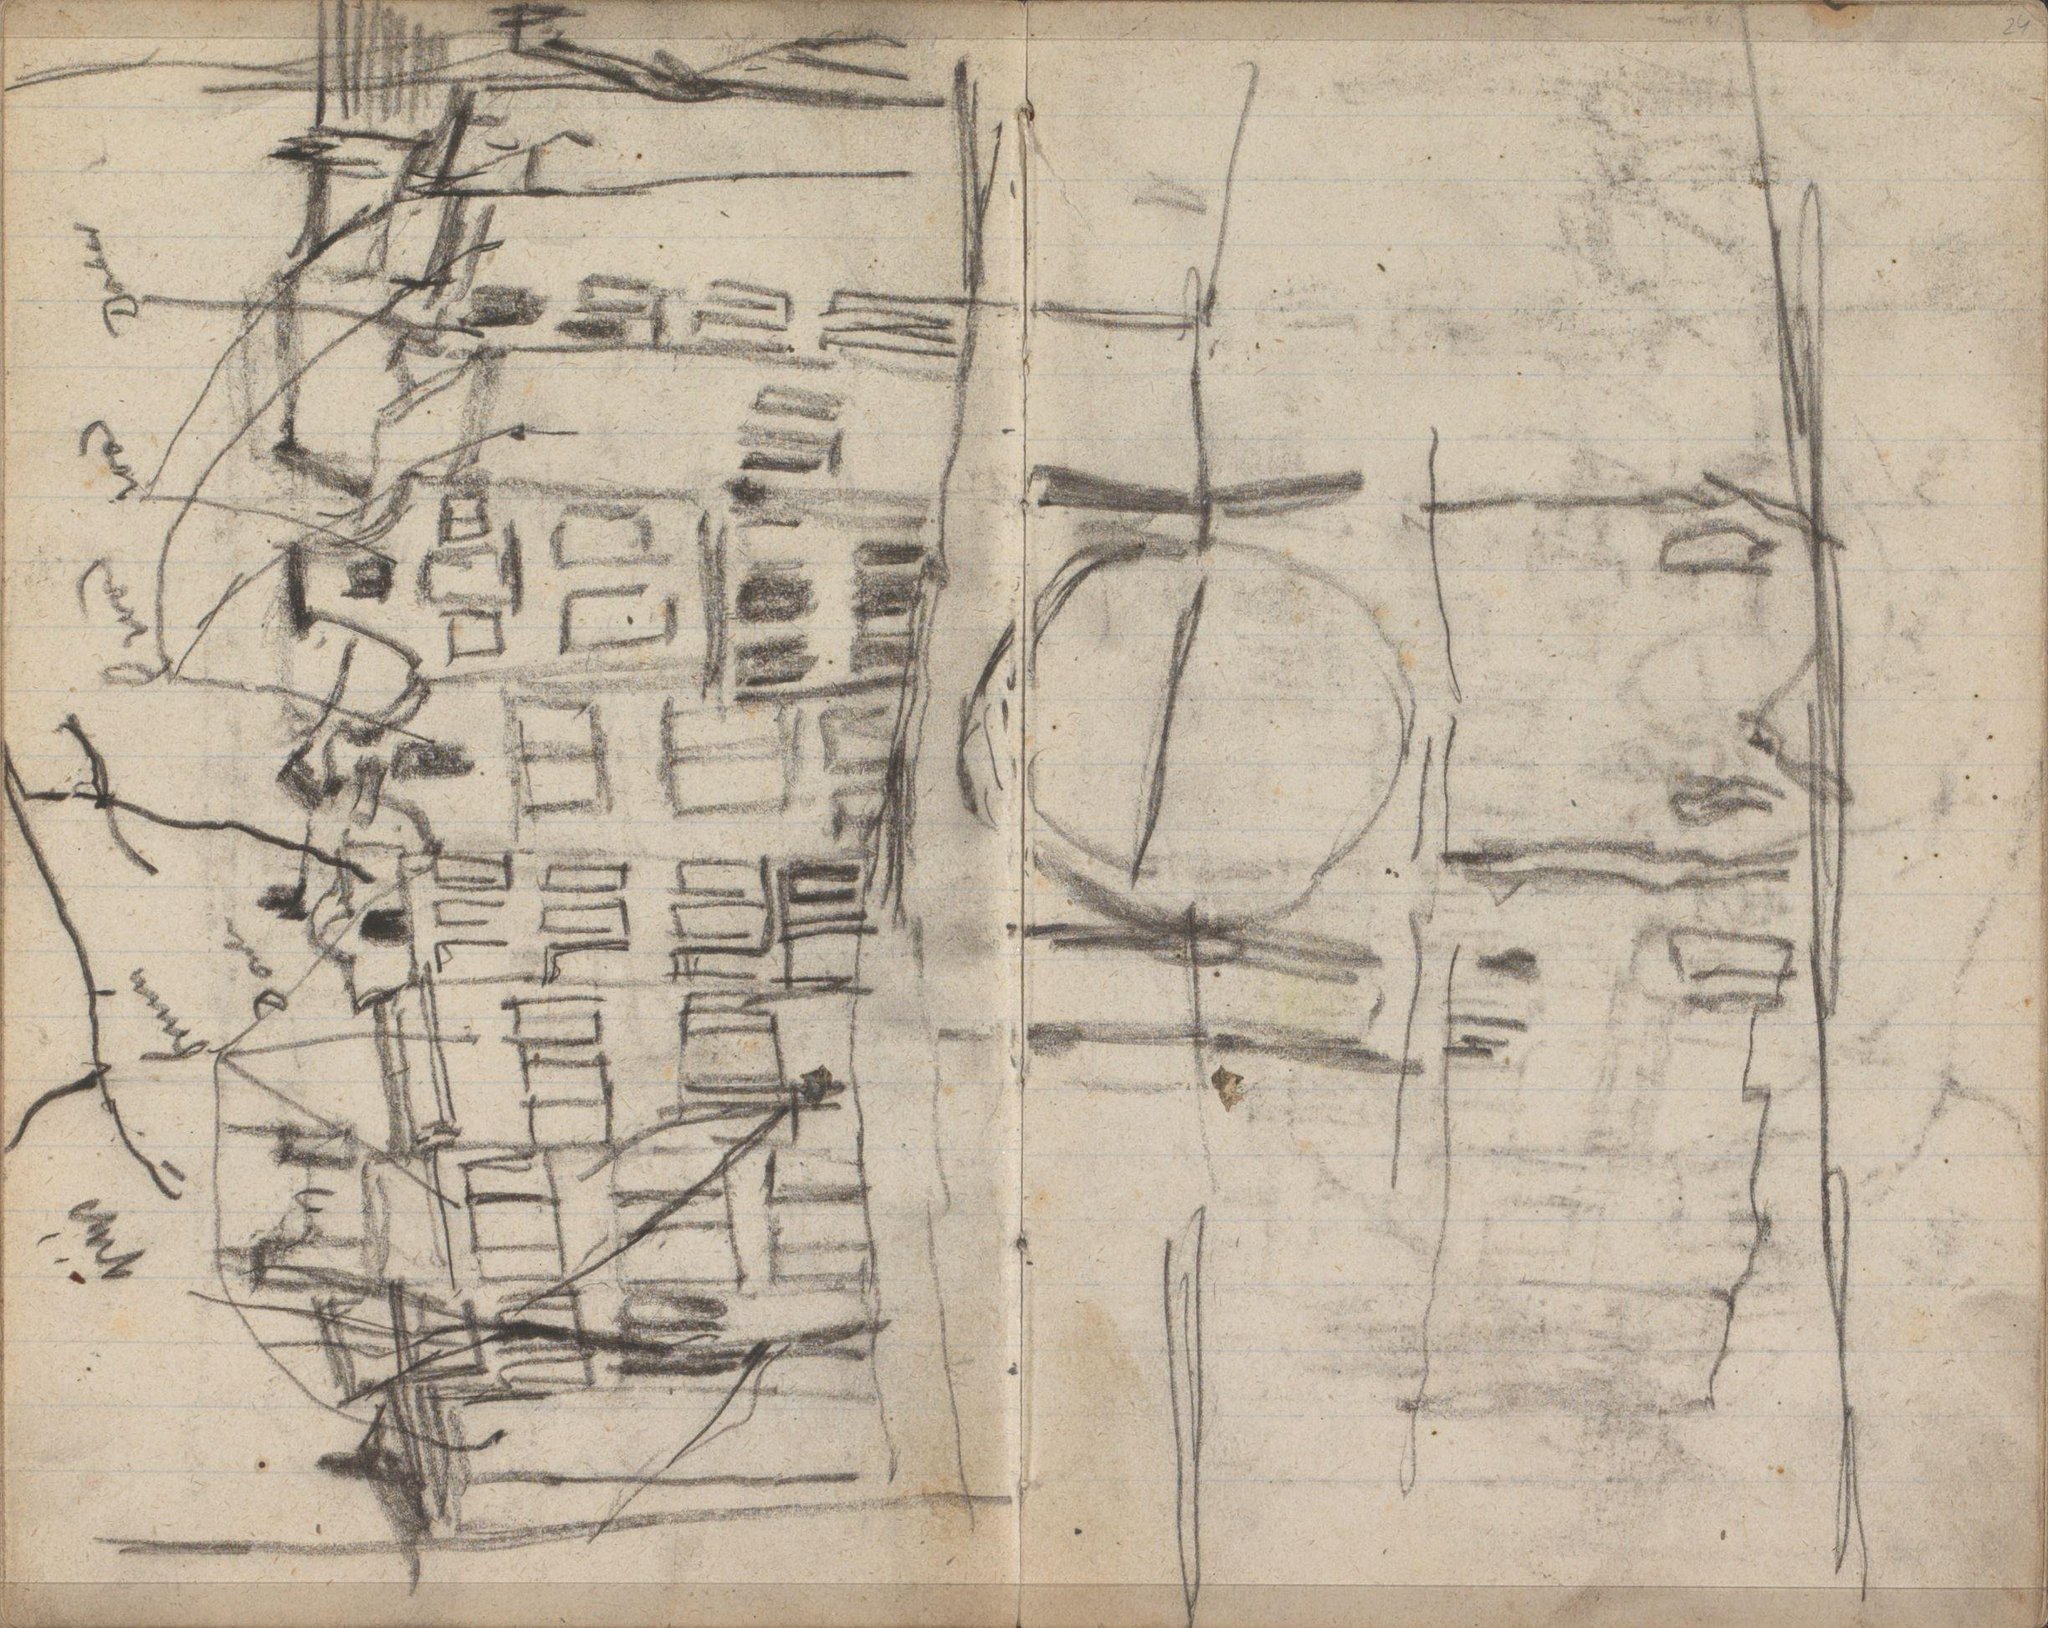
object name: sketchbook leaf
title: Brug over de Reguliersgracht te Amsterdam, gezien vanaf de Keizersgracht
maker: george hendrik breitner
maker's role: draughtsman, painter, print maker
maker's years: 1857-1923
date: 1898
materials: chalk, paper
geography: amsterdam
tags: bridge in city across river, canal, etc., civic architecture; edifices; dwellings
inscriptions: kleurnotitie, handgeschreven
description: Pagina 23 en pagina 24 uit een schetsboek met 31 bladen.